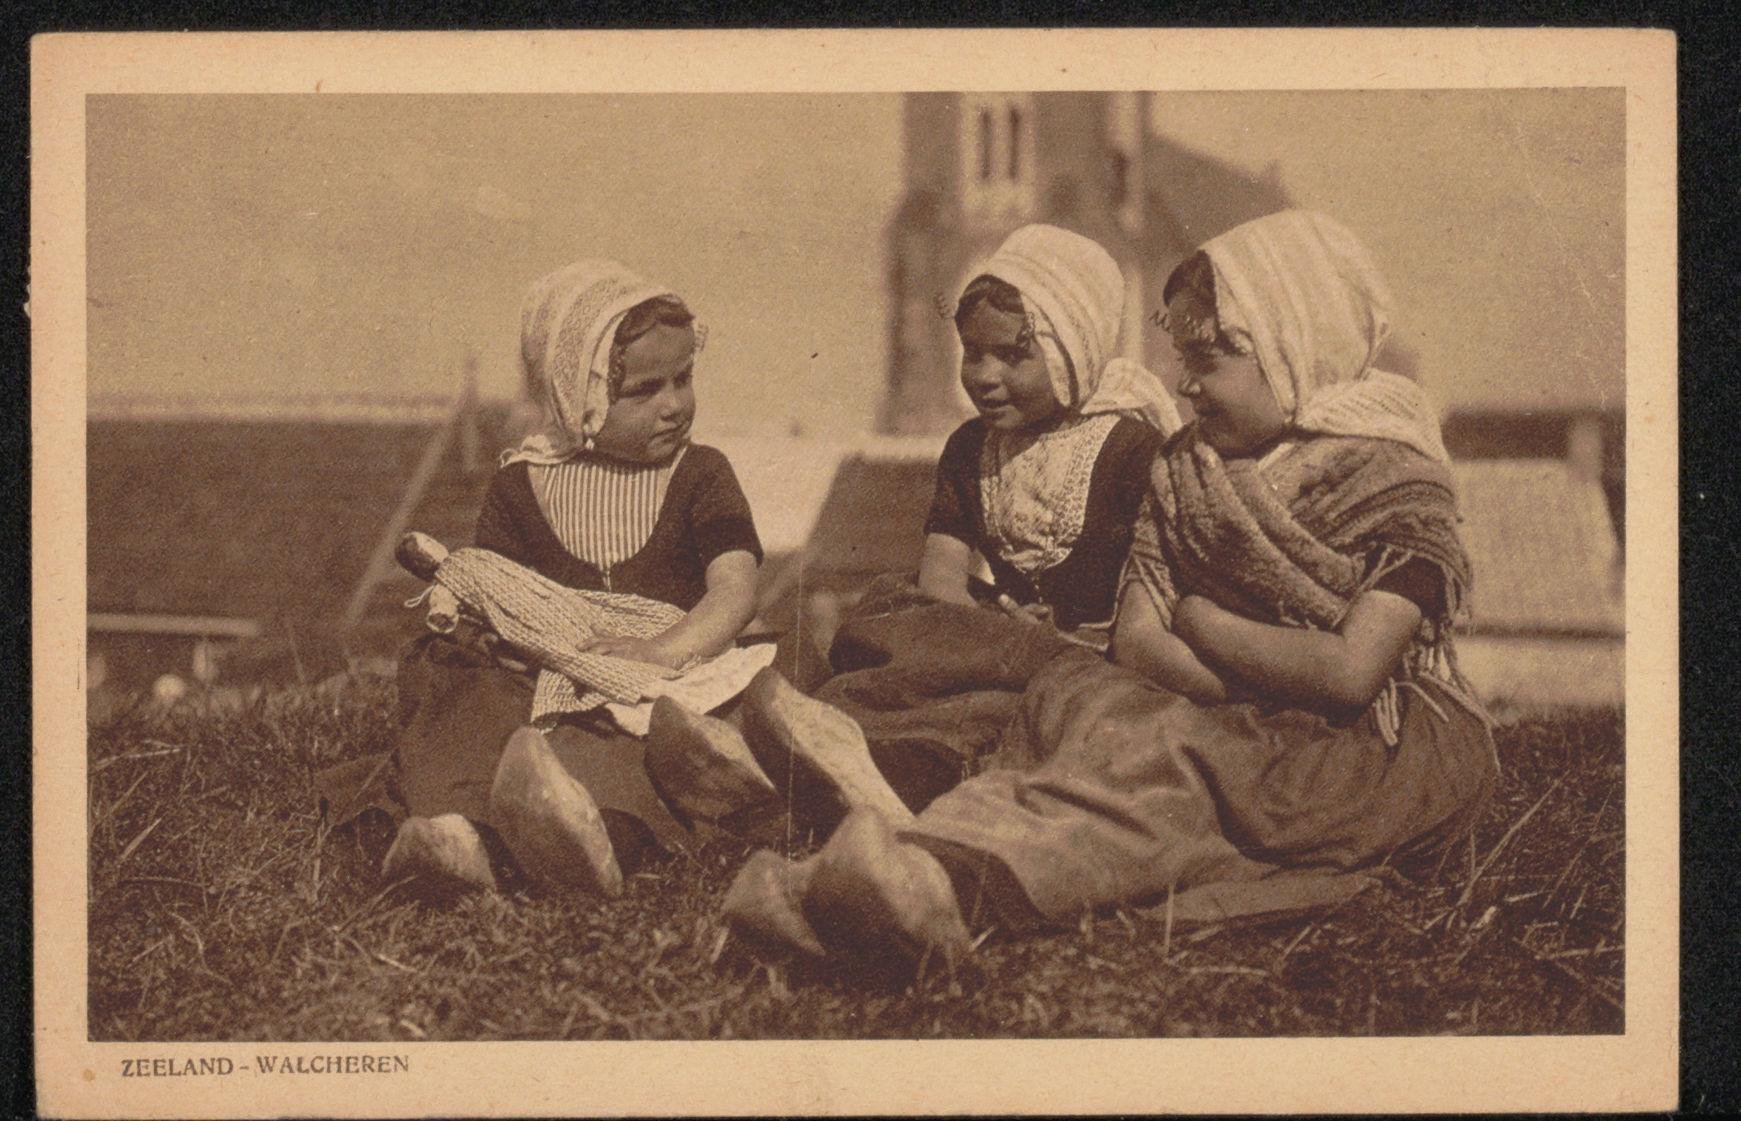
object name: ansichtkaart, prentbriefkaart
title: Prentbriefkaart aan Willem Bogtman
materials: cardboard, ink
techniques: pen, rotogravure, writing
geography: zundert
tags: indonesia, the hague, willem bogtman, printed matter